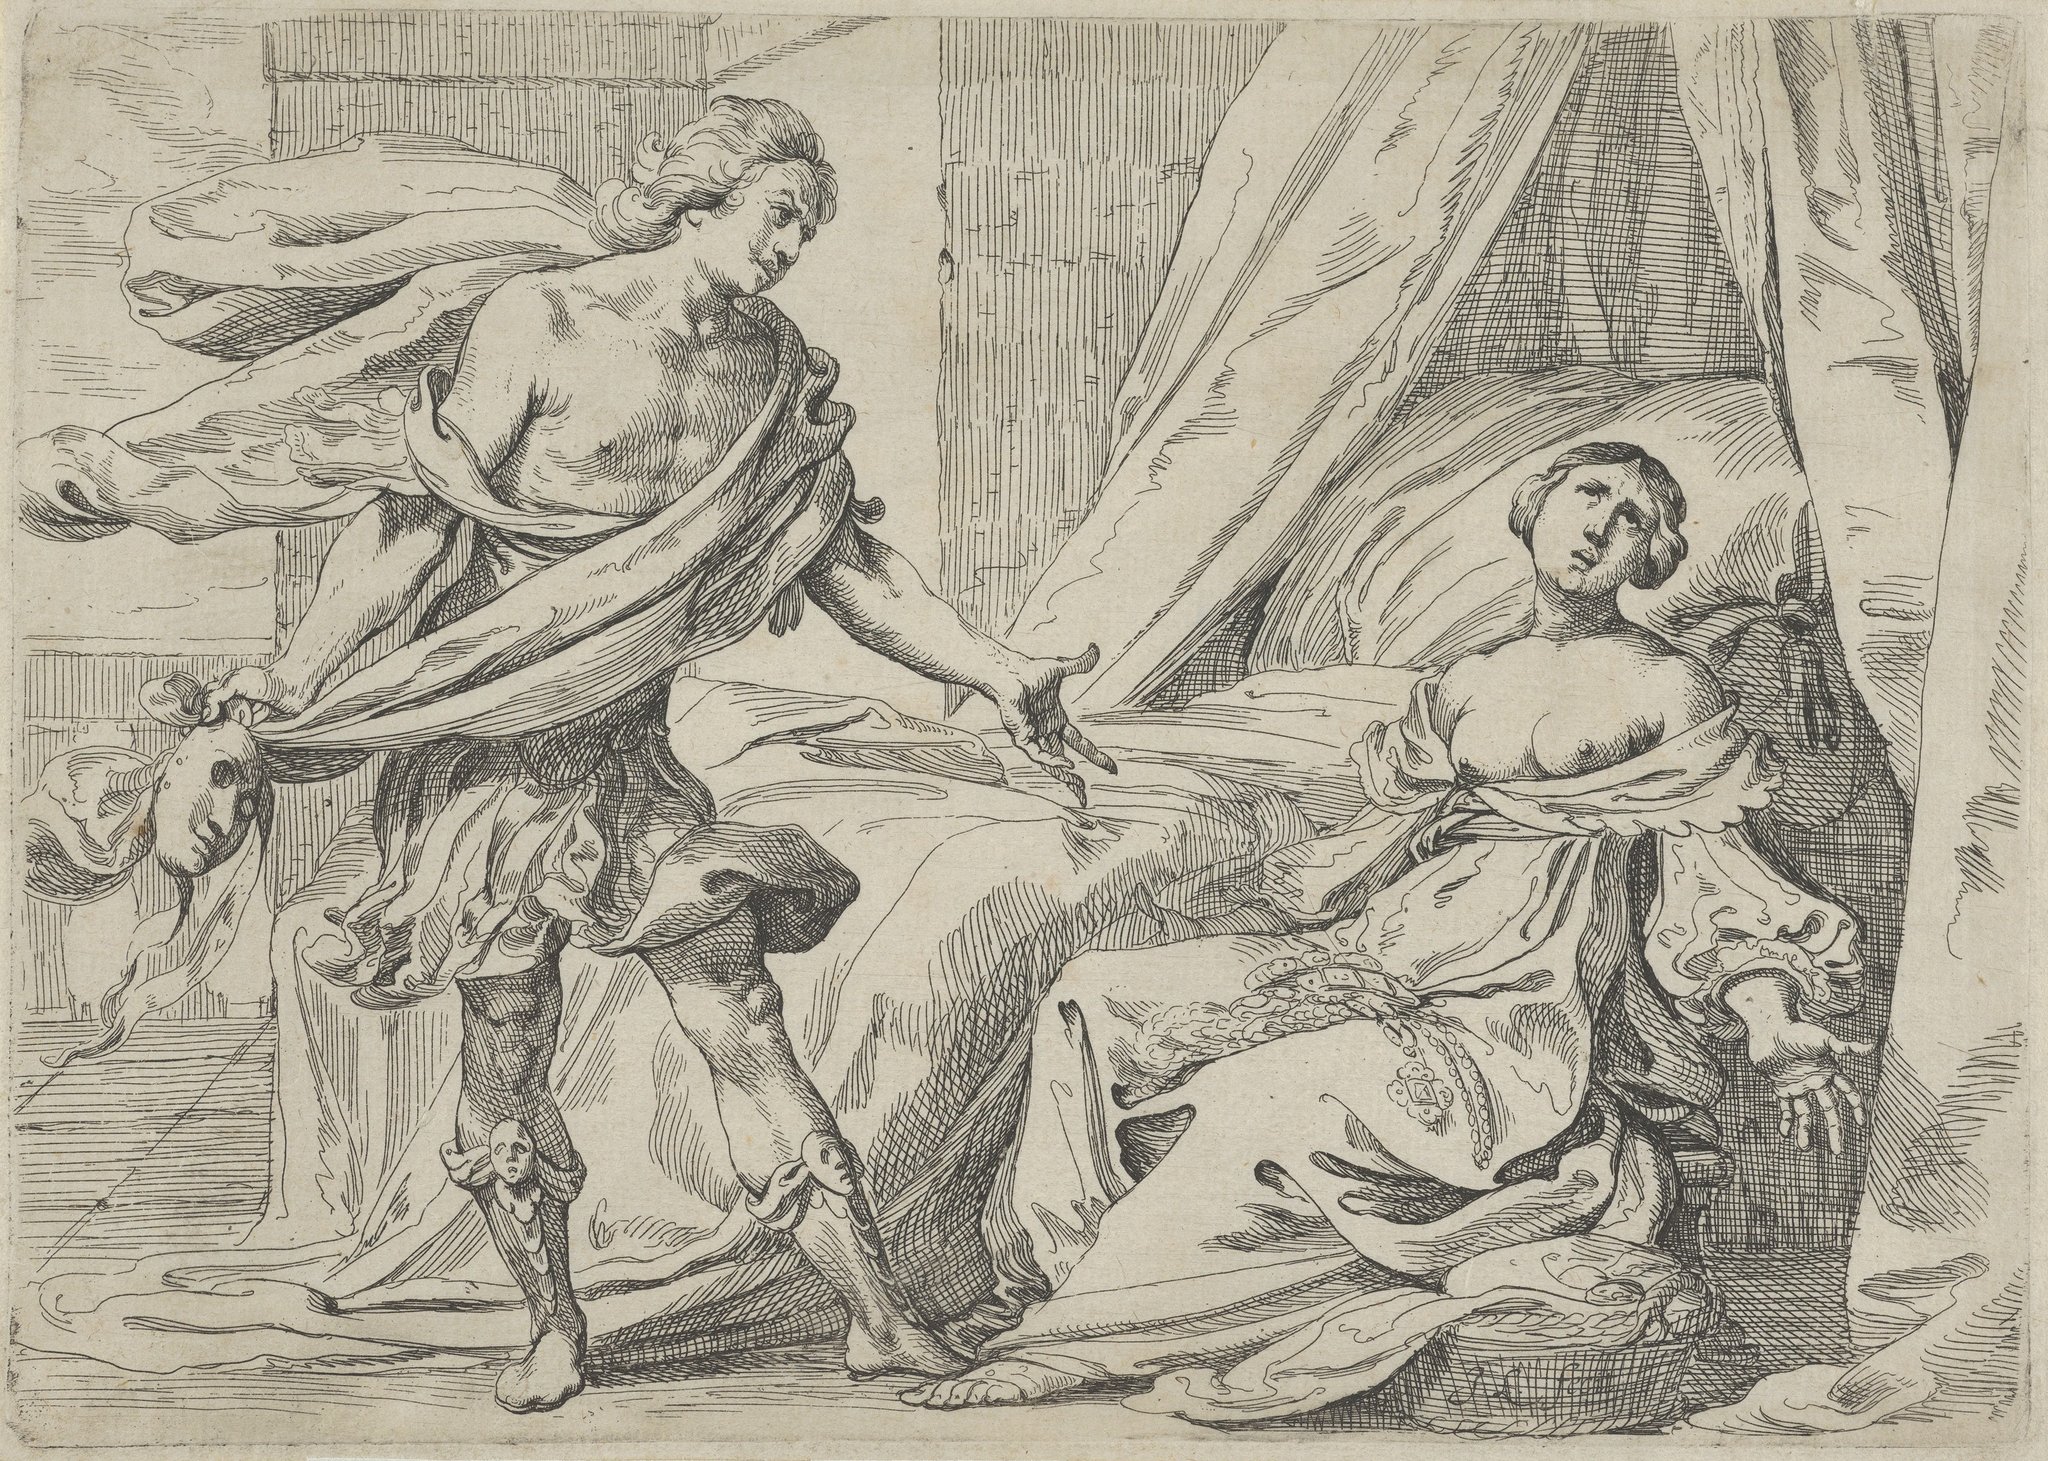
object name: print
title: Cephalus and Procris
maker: johann liss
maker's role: artist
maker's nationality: german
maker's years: 1595-1631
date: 1595-1631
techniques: etching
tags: masks,men,female nudes,beds